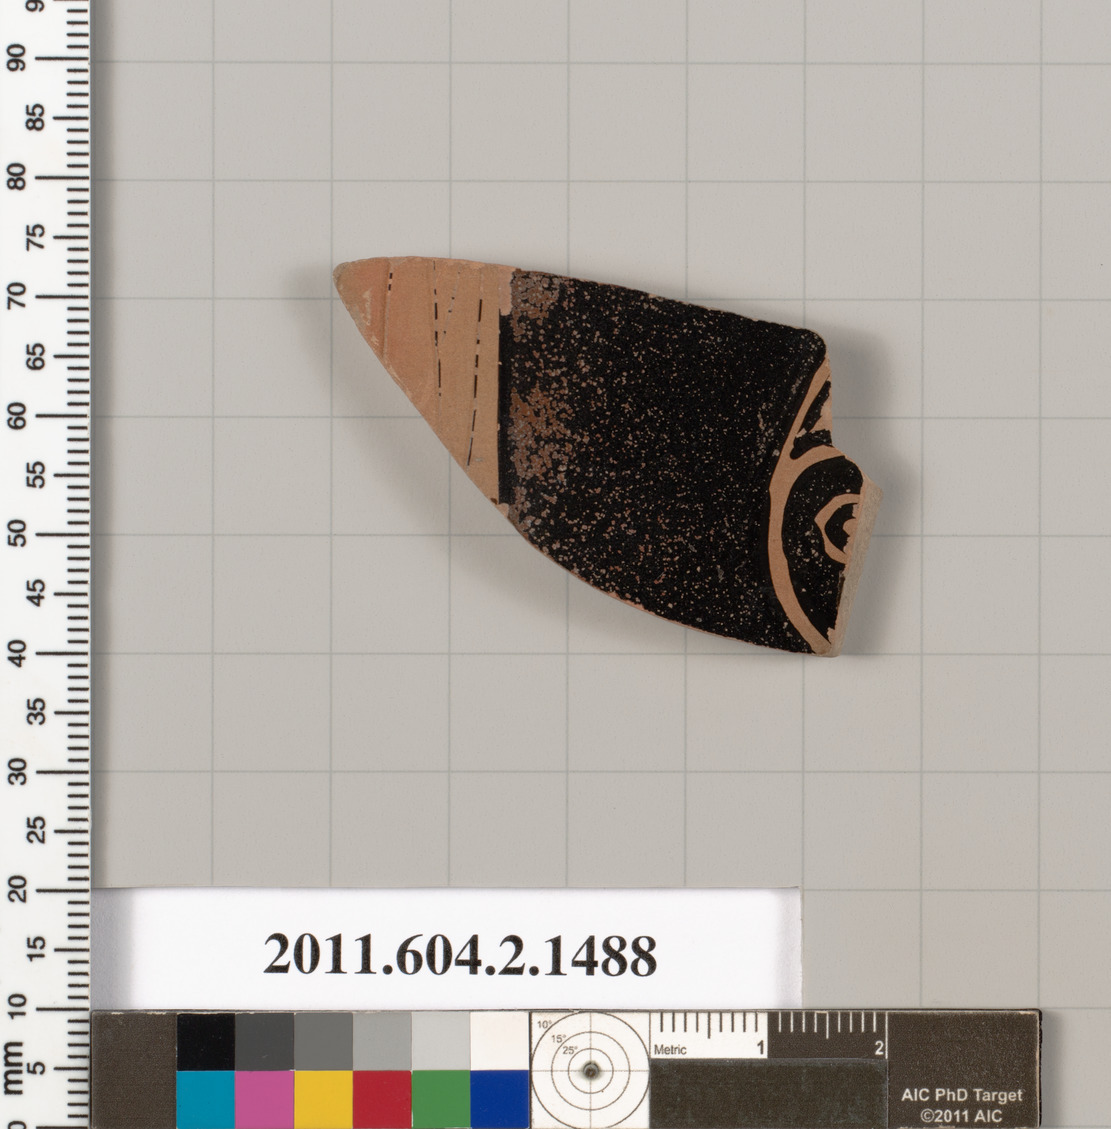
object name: skyphos fragment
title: Terracotta fragment of a skyphos (deep drinking cup)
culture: greek, attic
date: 460-440 BCE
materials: terracotta